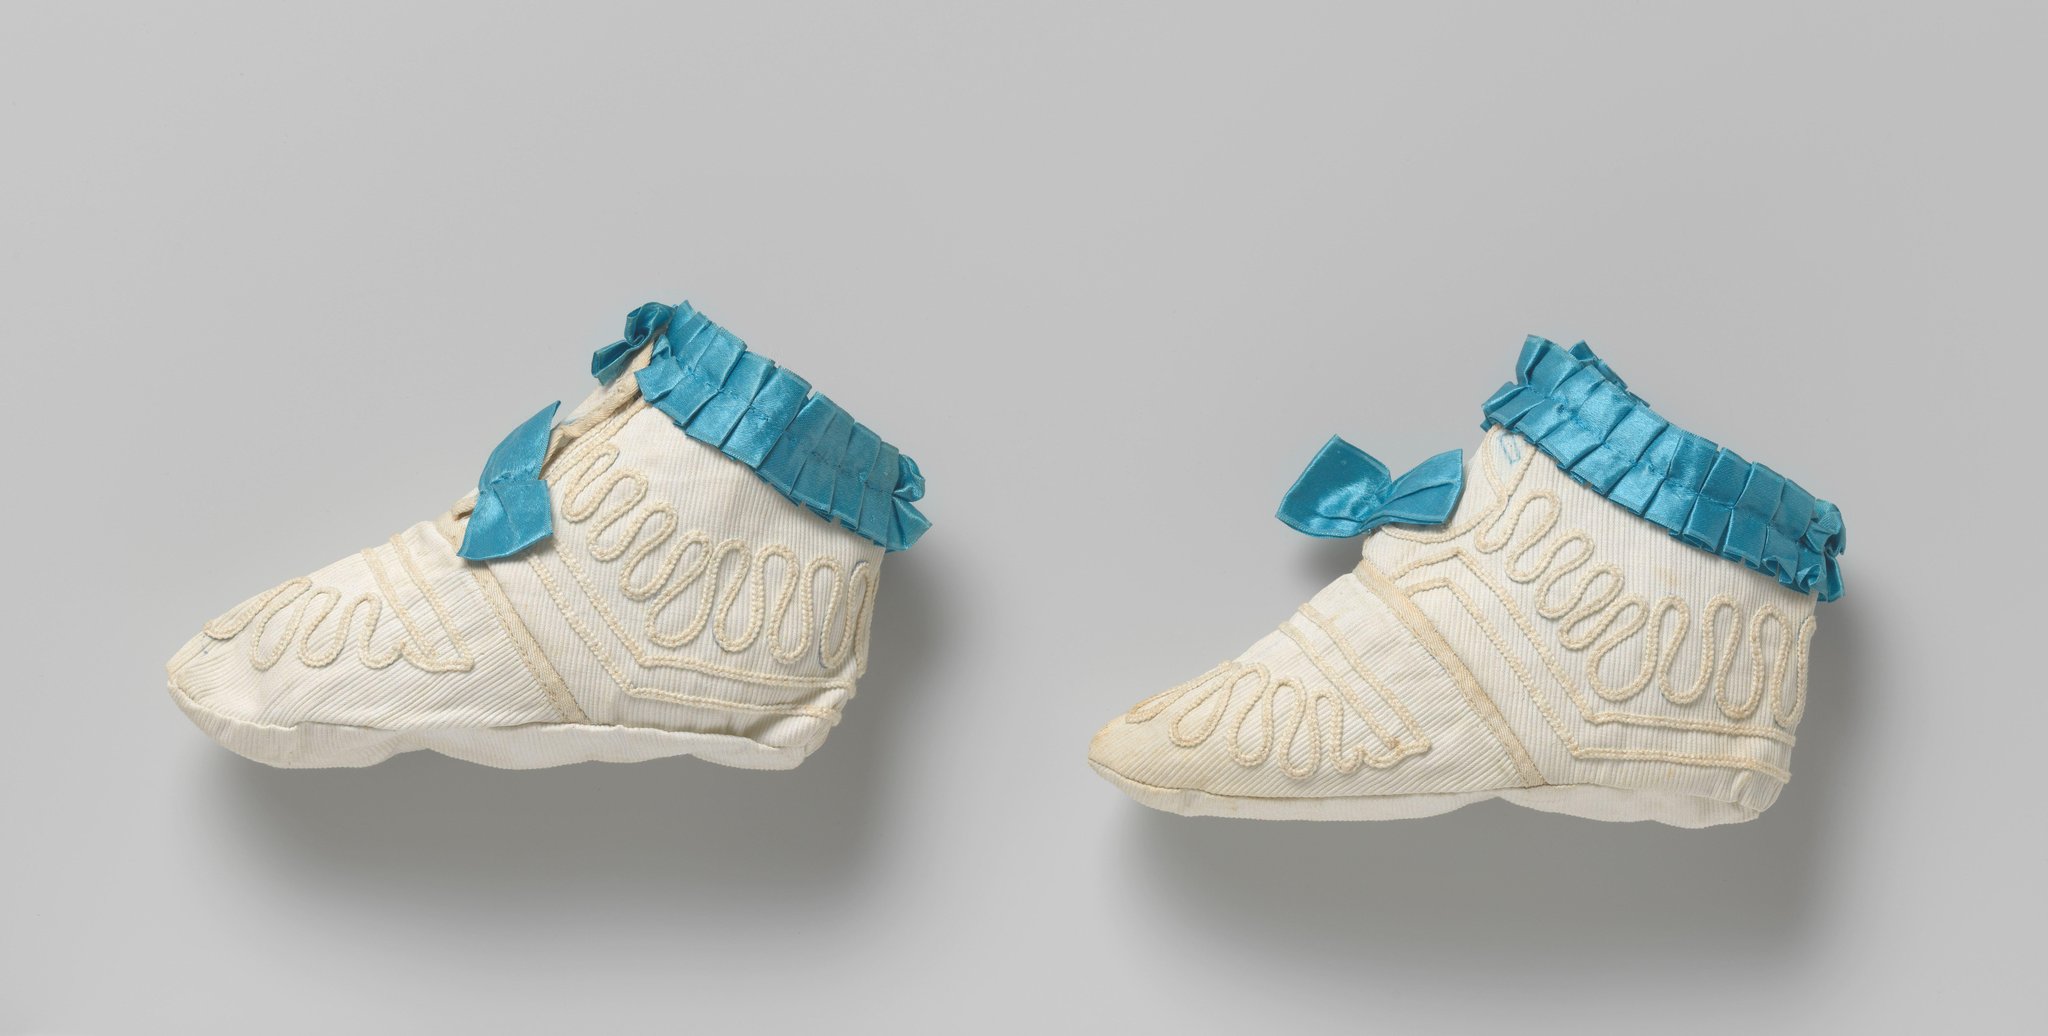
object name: shoe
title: Babyschoen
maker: Anonymous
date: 1877-1878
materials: textile, ribbon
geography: amsterdam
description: Babyschoen van piqué en blauw lint. Lage laars, met afgerond voorblad, schacht en aangenaaide zool van dezelfde stof. Sluiting middenvoor, met haak en trensje. De stof is belegd met wit soutache in een slingerpatroon. De bovenranden met een geplisseerd fel blauw lintje afgeboord. Met strikje.